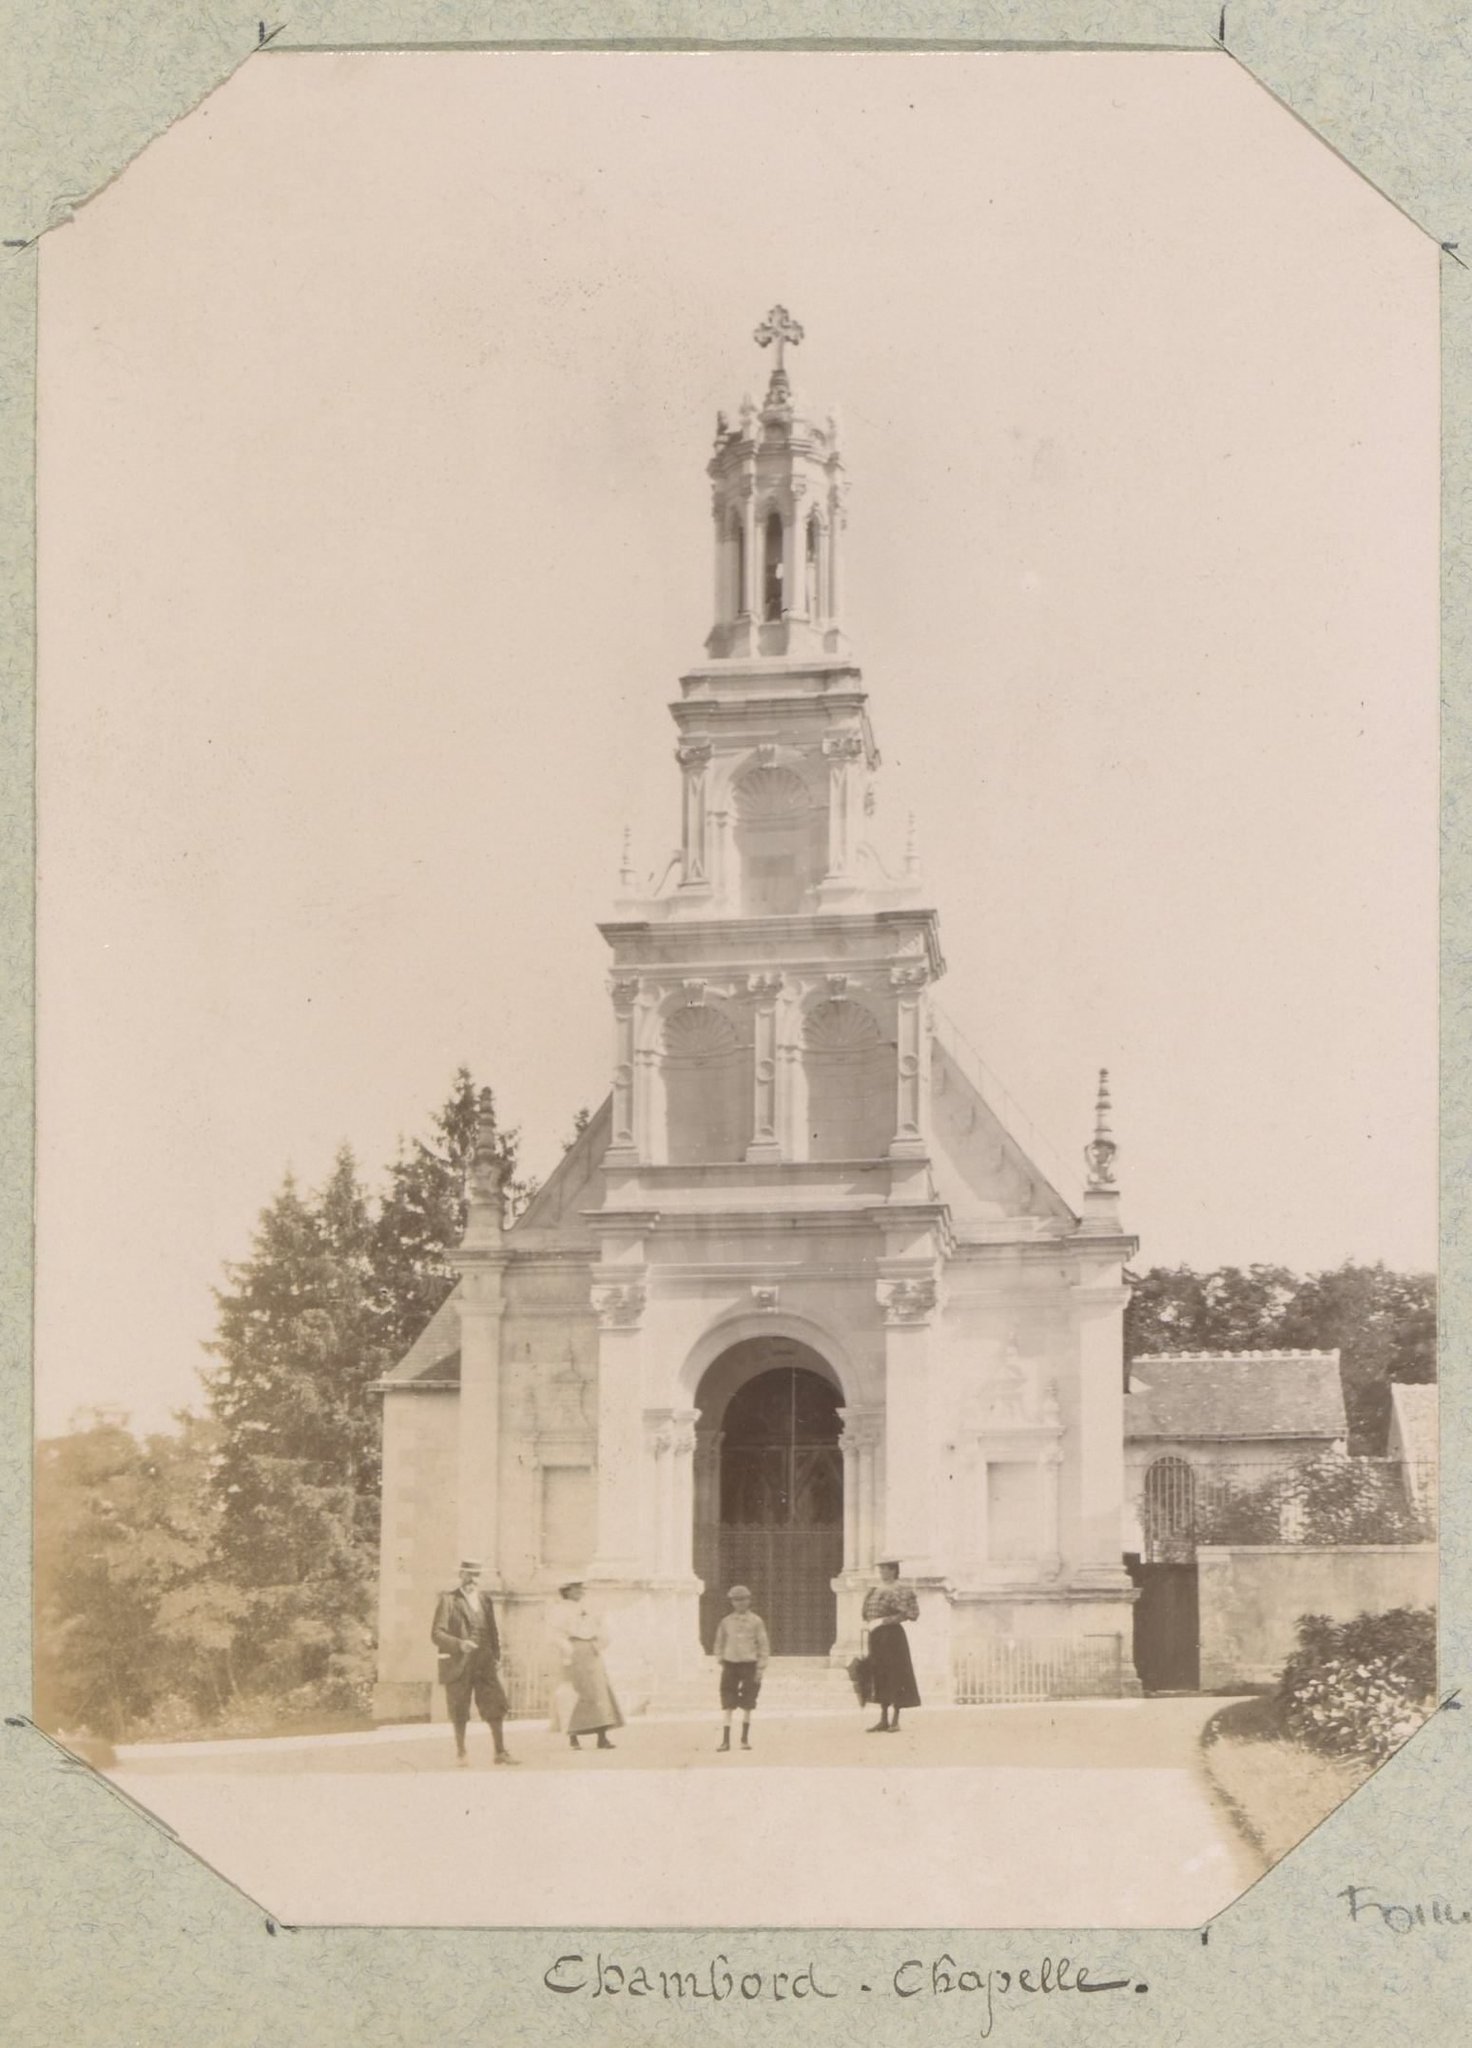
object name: photograph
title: Vier personen voor de kapel van het kasteel van Chambord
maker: Anonymous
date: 1890-1900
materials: paper, photographic support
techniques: daylight paper print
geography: chambord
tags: castle, church (exterior) - qq - small church, chapel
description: Onderdeel van Album van een Franse amateur met foto's van Frankrijk, Algerije, Palmyra, de Wereldtentoonstelling van 1900 en van bekende Fransen.